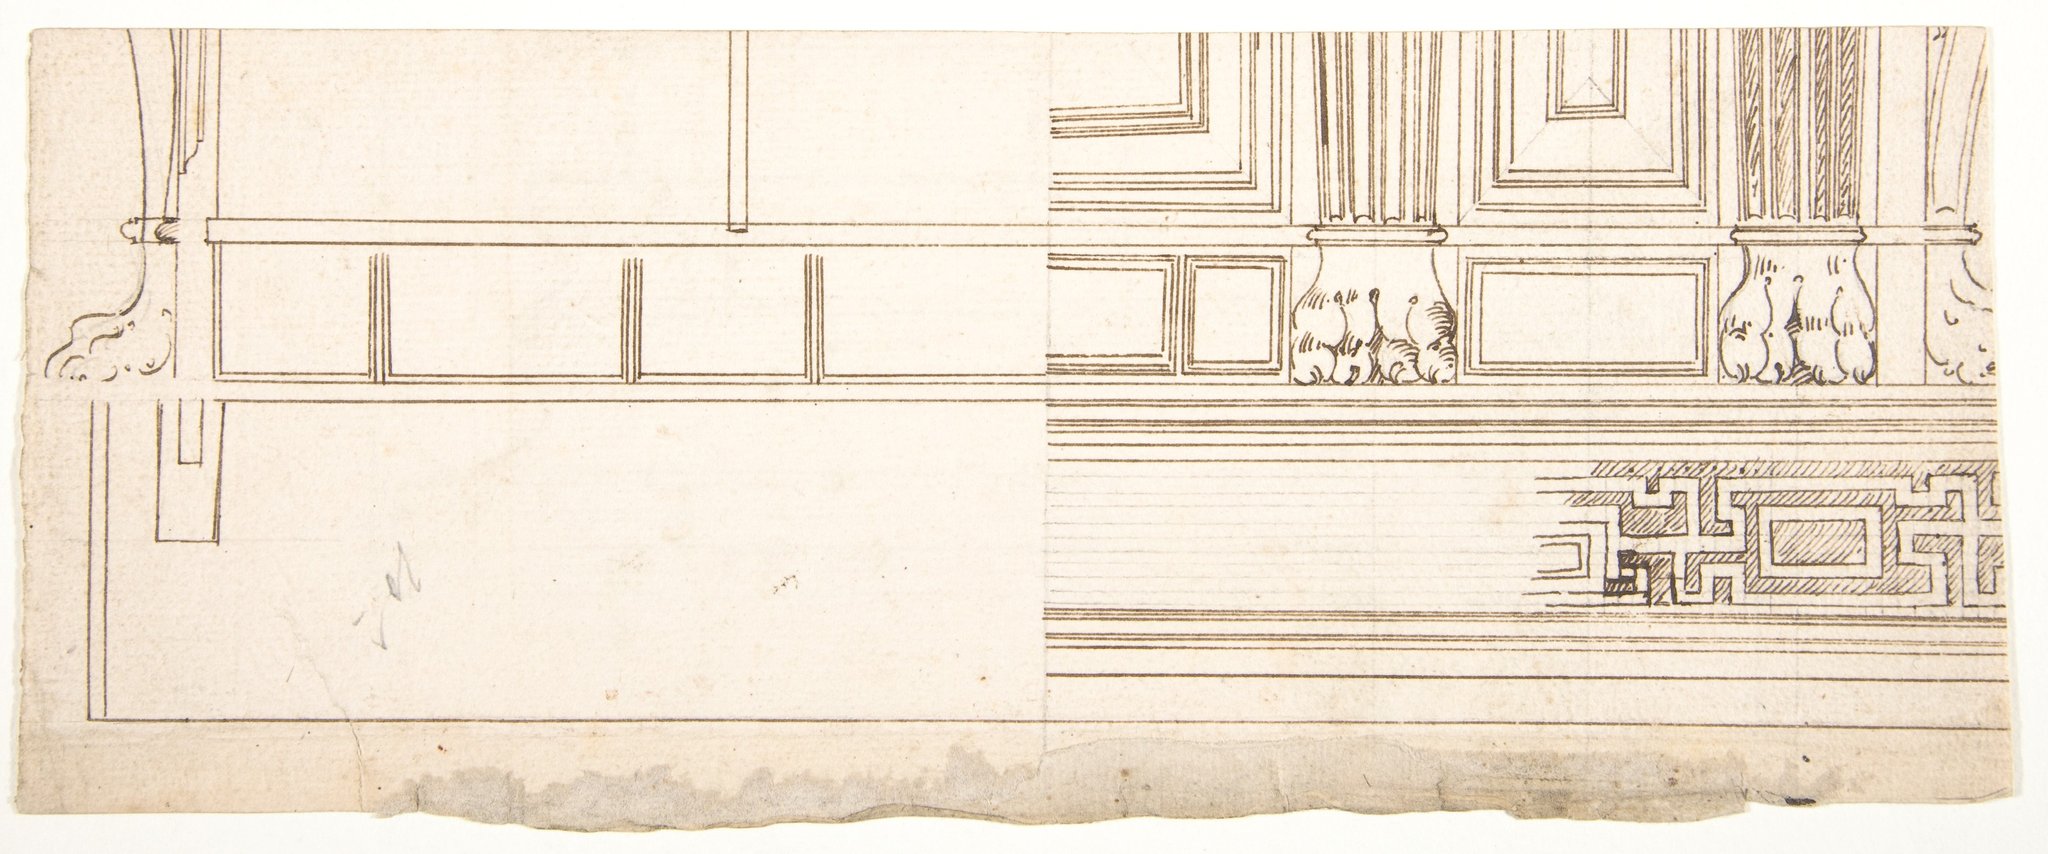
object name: collection ornament architecture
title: Unidentified building, elevation and section elevation (recto) Corinthian column base, elevation (verso)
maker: anonymous, french, 16th century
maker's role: draftsman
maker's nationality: french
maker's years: 1500-1600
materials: chalk, ink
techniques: incising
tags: architecture